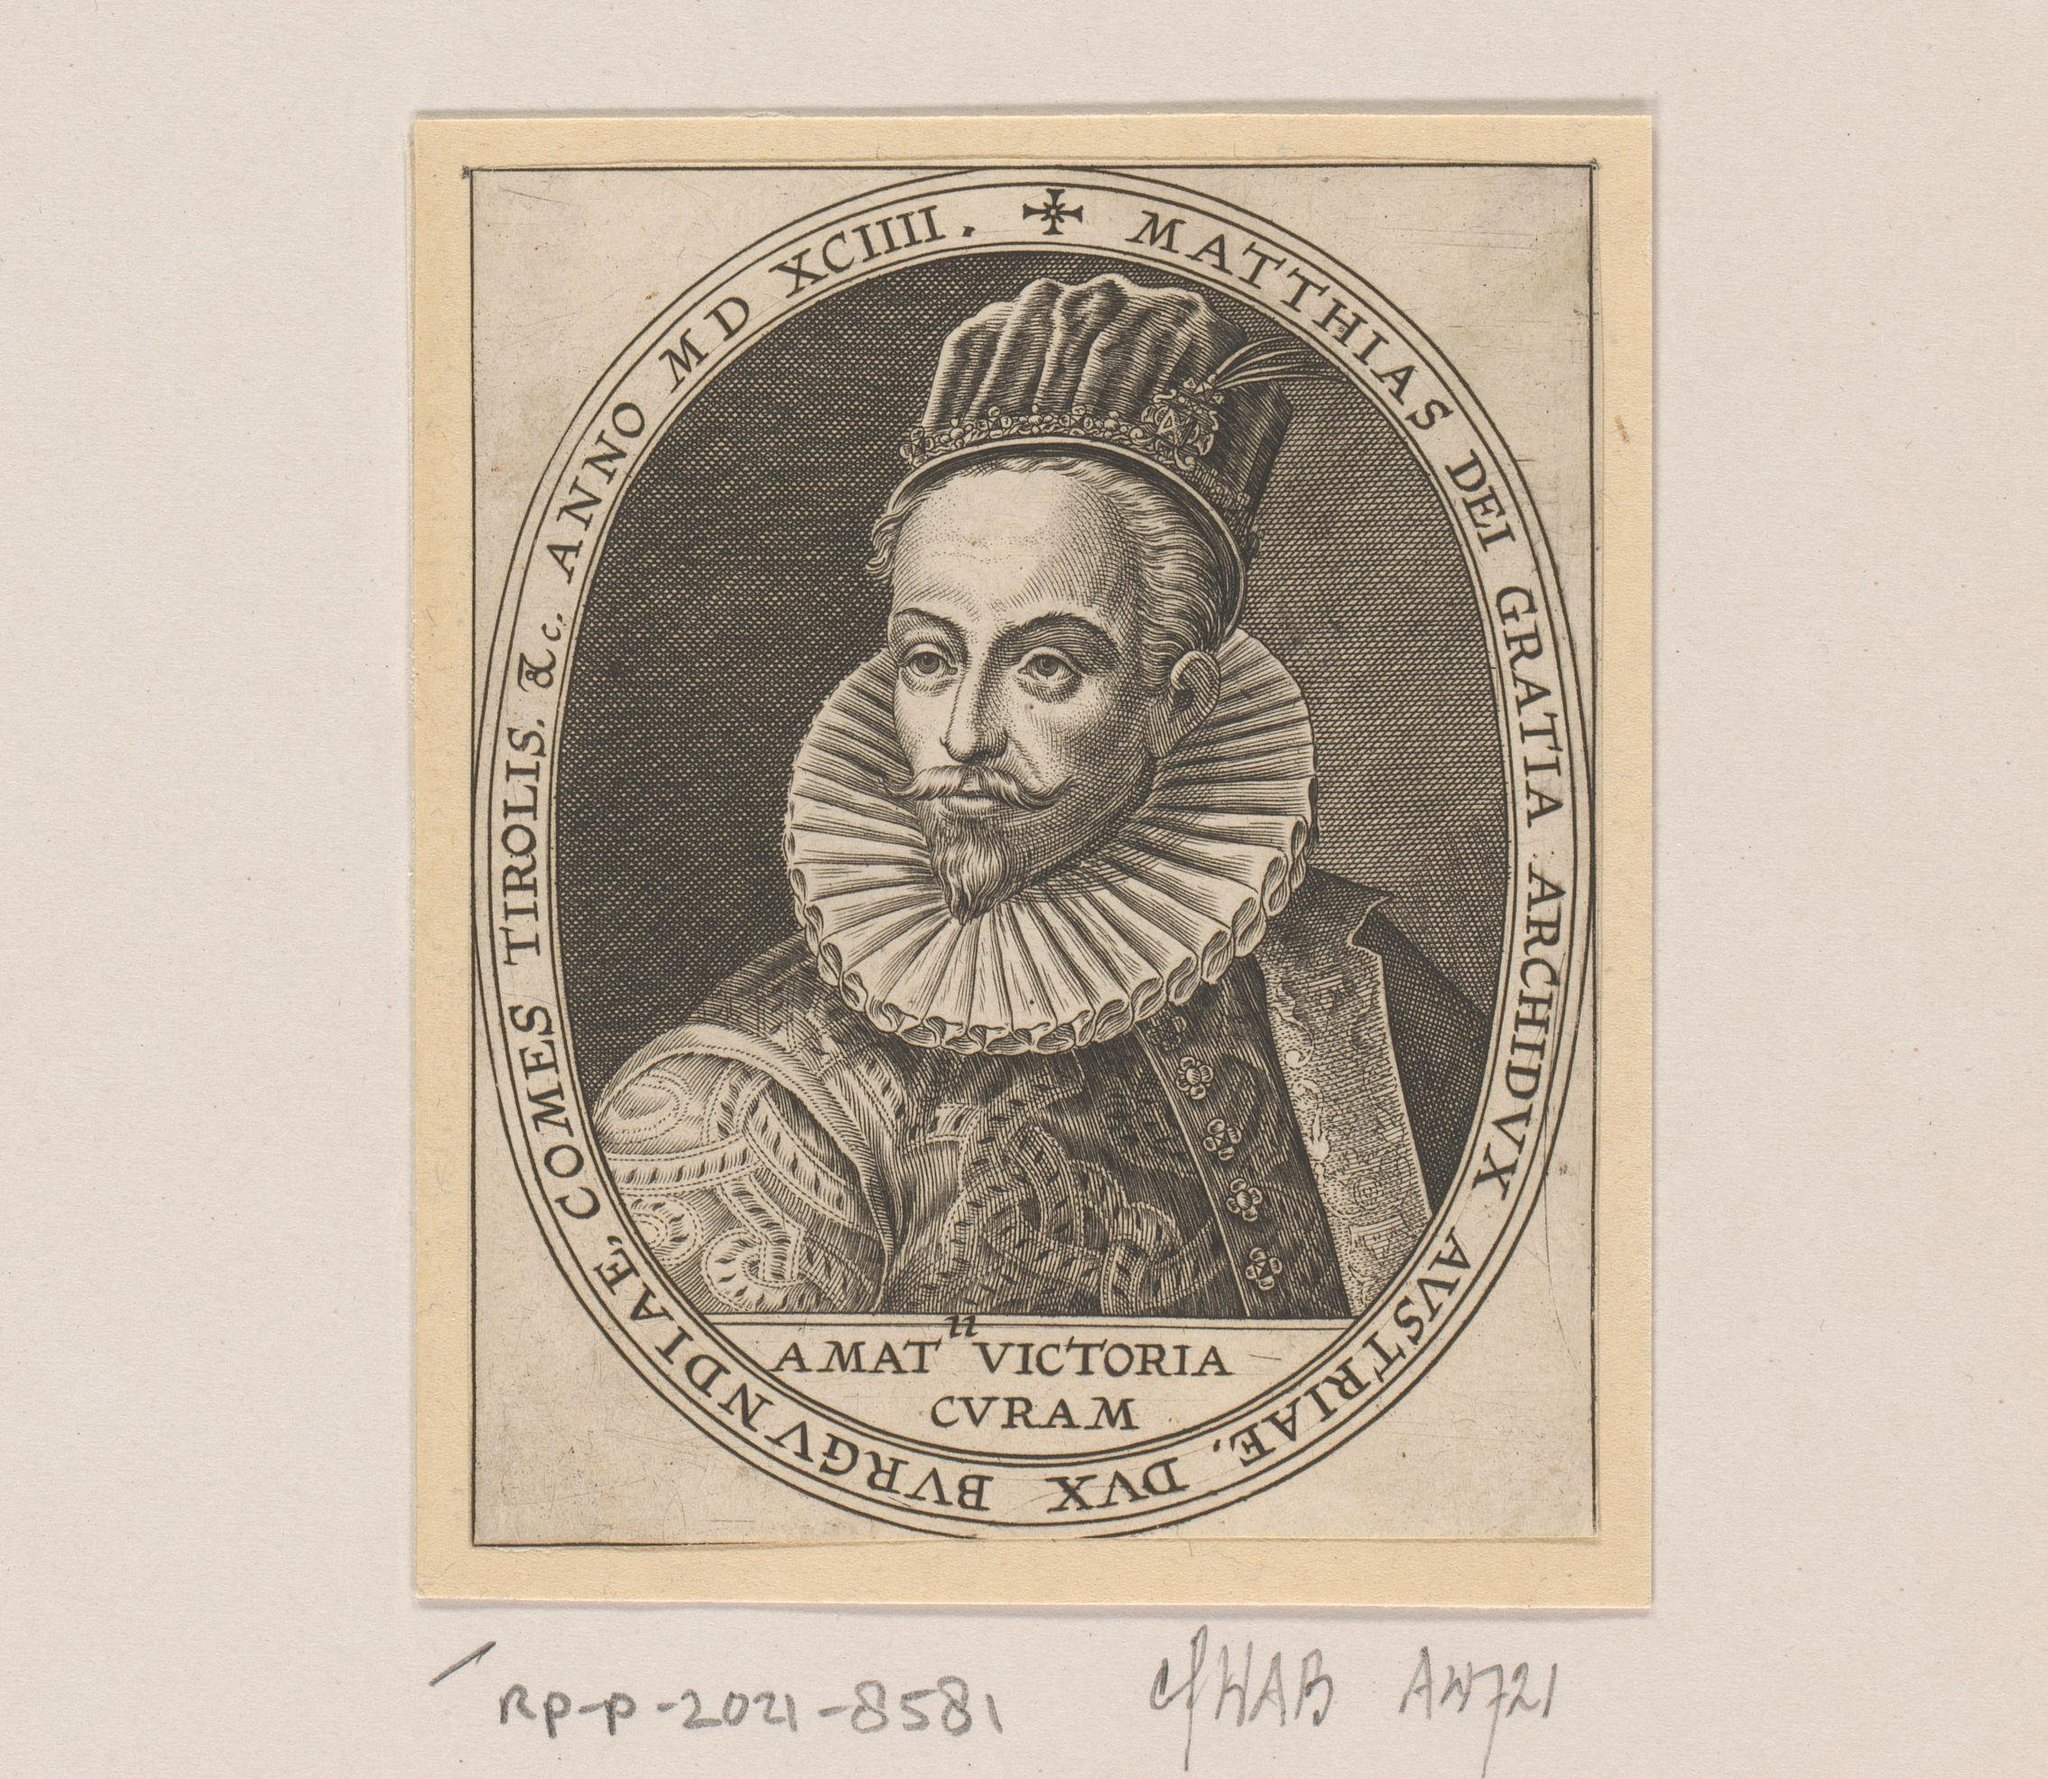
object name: print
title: Portret van keizer Matthias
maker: Anonymous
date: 1594-1620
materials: paper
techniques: engraving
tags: vienna, matthias van oostenrijk (rooms-duits keizer), historical persons, emperor